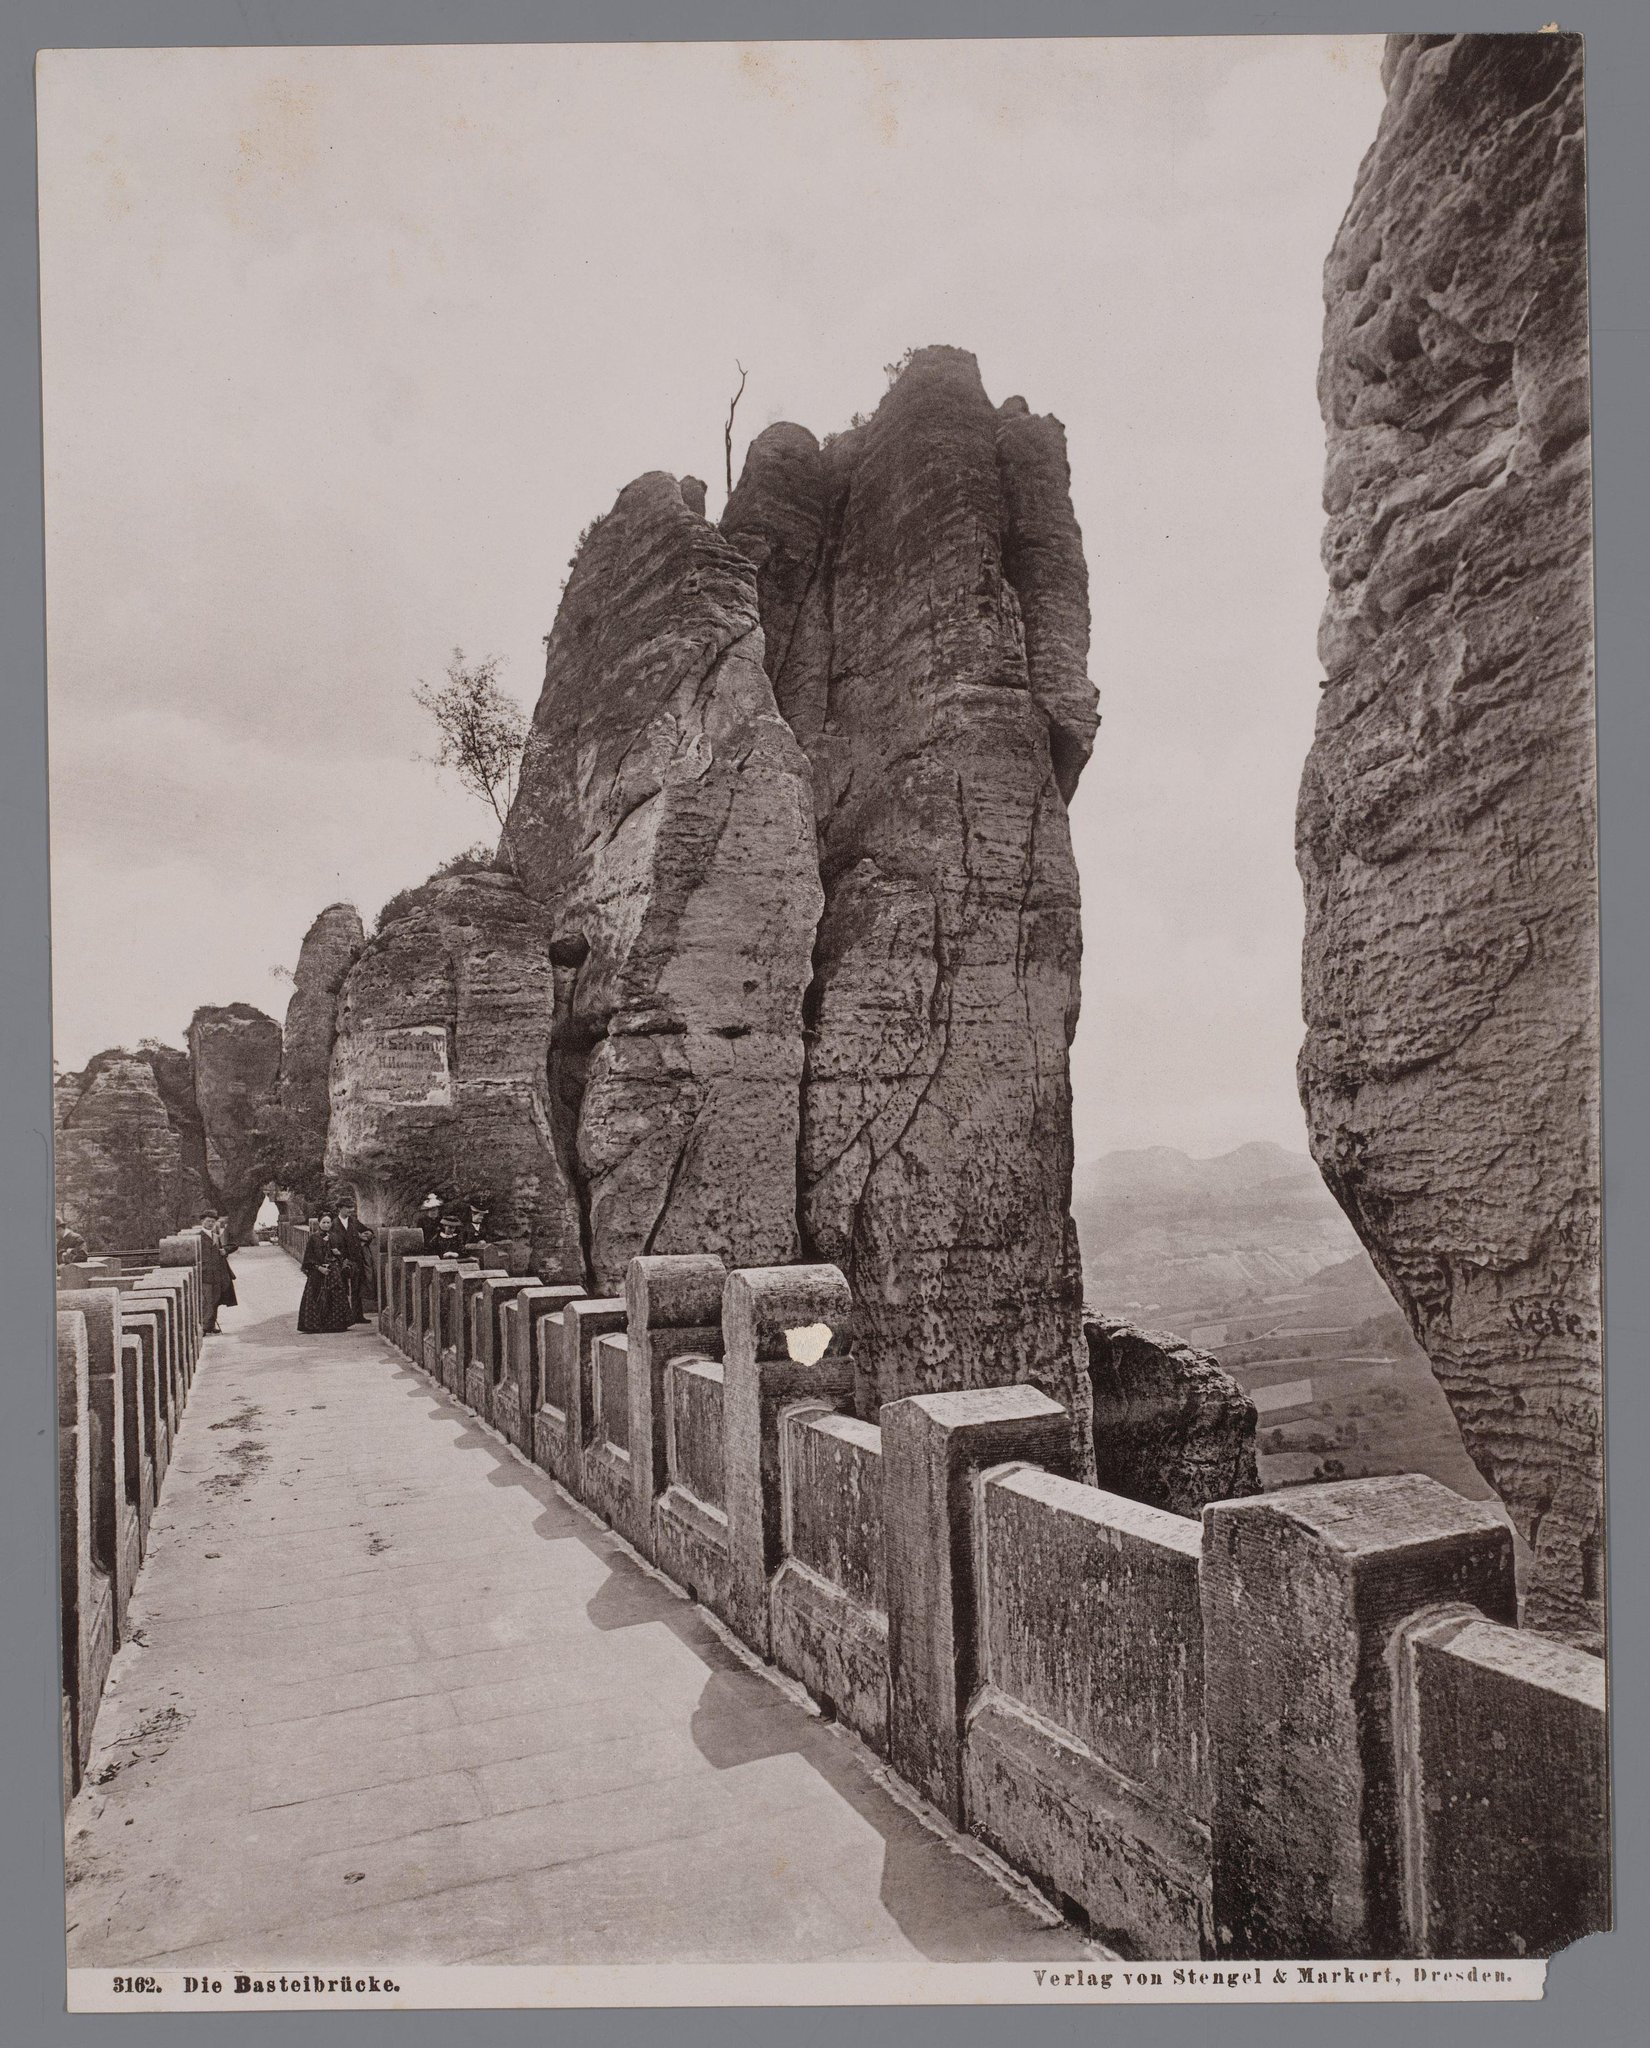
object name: photograph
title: Basteibrücke, nabij Rathen, Saksen, Duitsland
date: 1890-1920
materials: paper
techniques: photoaquatint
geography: germany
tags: saksen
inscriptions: inscription: ‘in de lengte//5’, inscription: ‘Verlag von Stengel & Markert, Dresden.’, inscription: ‘3162. Die Basteibrücke’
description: Foto op brug genomen, er zijn mensen te zien die uitkijken over het landschap. De brug wordt gekenmerkt door enkele markante rotspunten. De ligging is bij het kuuroord Rathen in Saksisch Zwitserland, een gebied (Landkreis) in de Duitse deelstaat Saksen. Saksisch Zwitserland is ook de naam voor het nationale park in de streek tussen het Elbsandsteingebirge en de Tjechische grens.